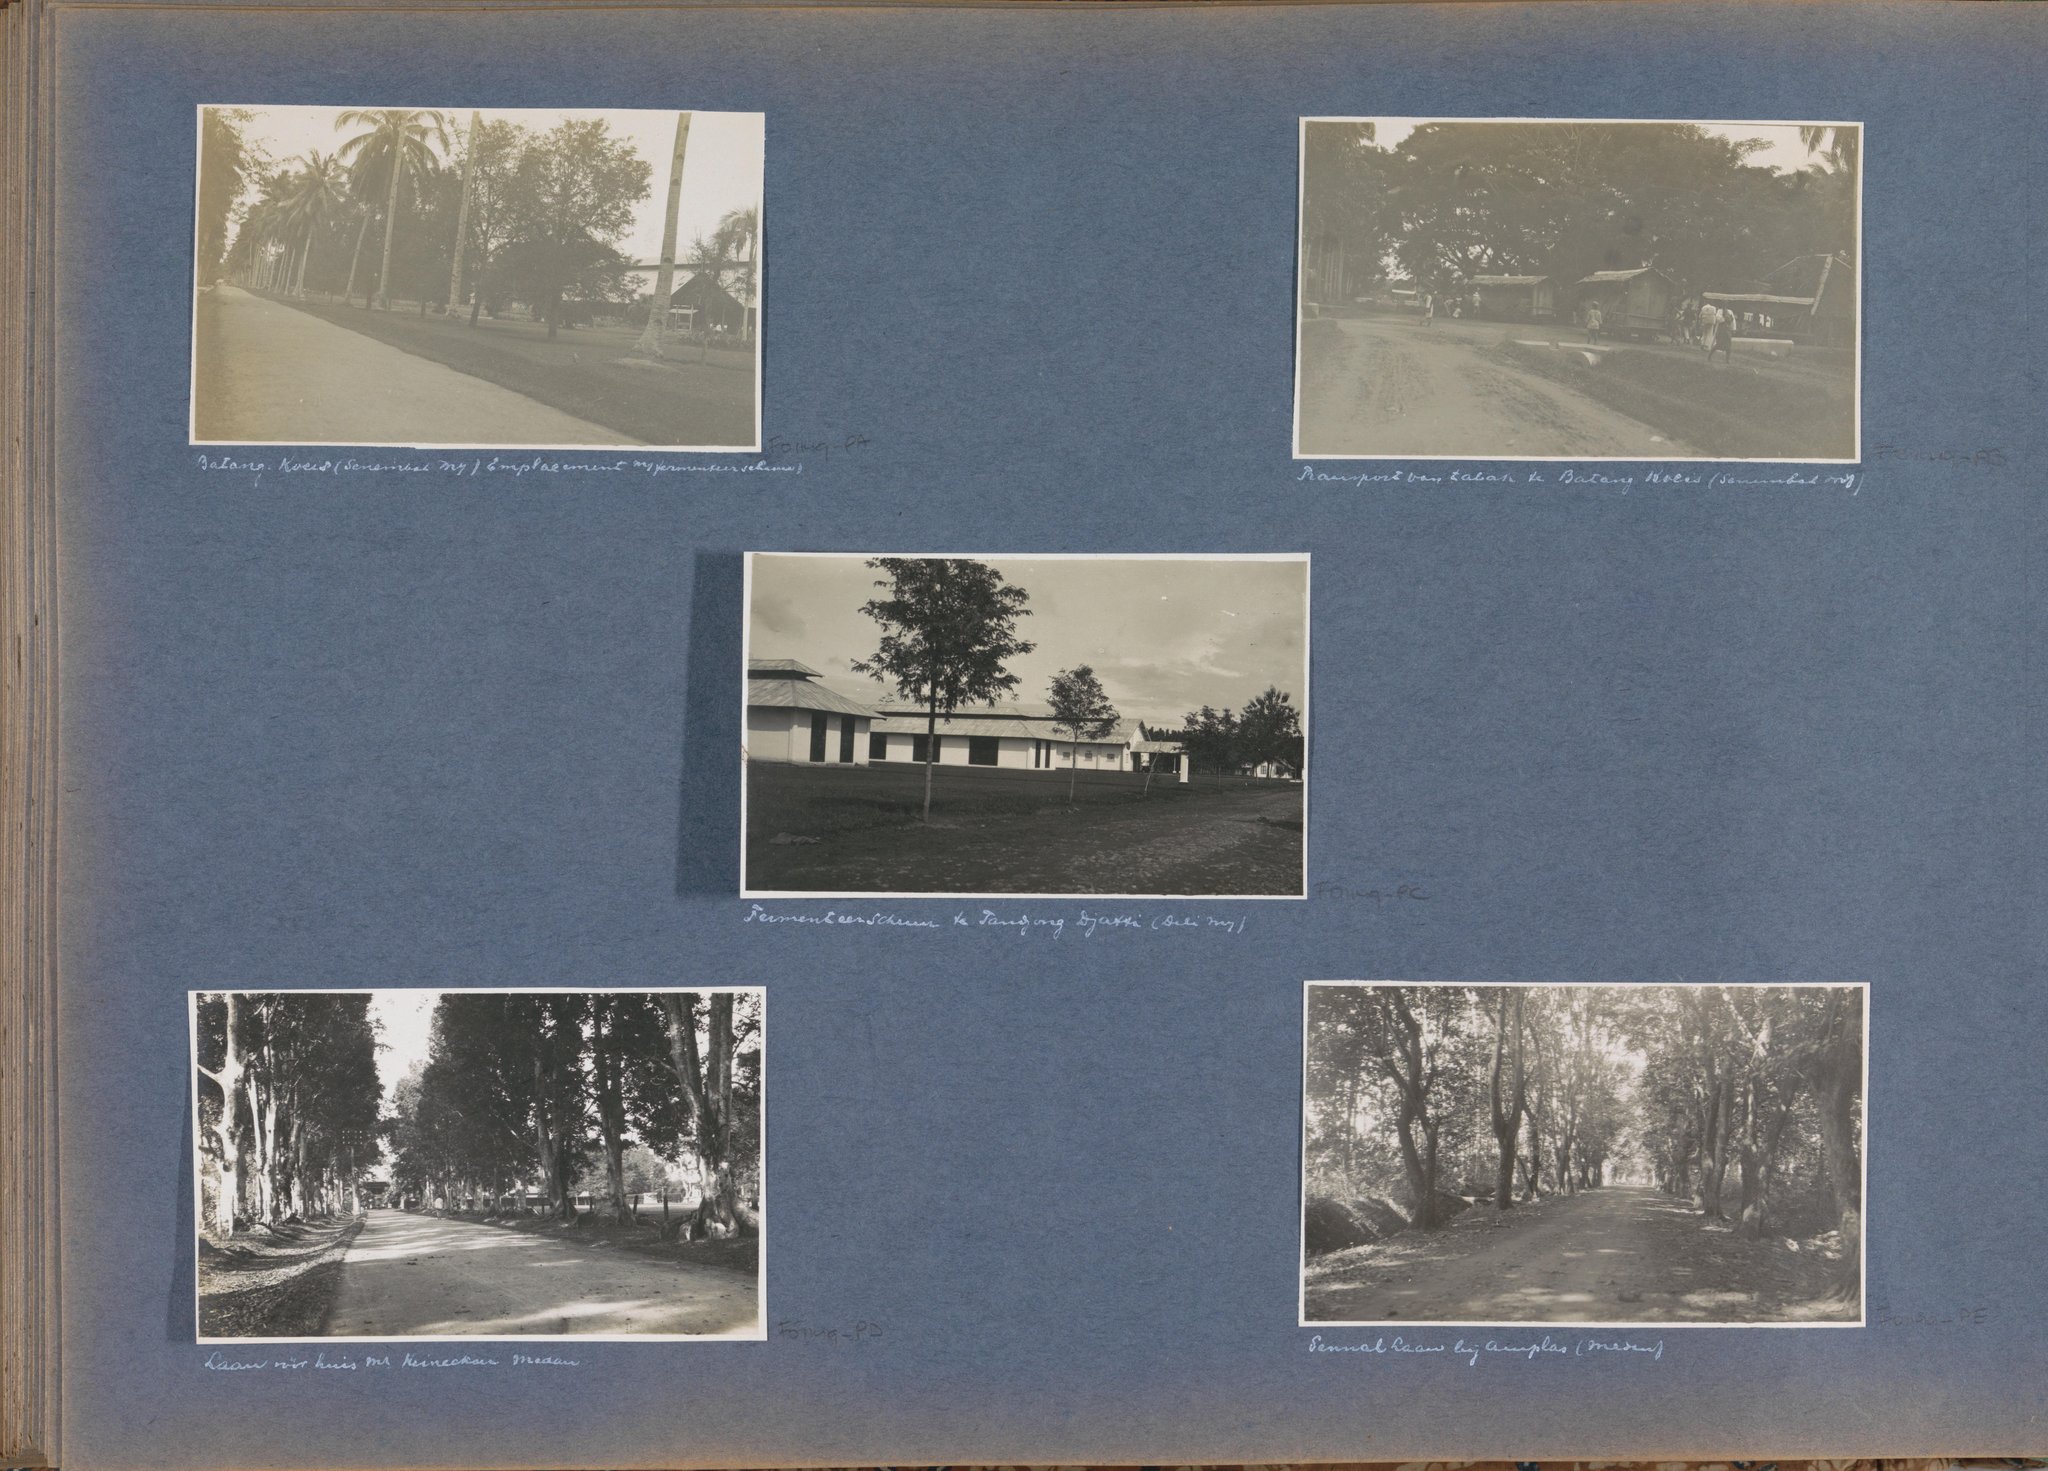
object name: photograph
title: Emplacement bij fermenteerschuur van de Senembah Maatschappij te Batang Kuis op Sumatra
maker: Anonymous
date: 1900-1920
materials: paper, photographic support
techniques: gelatin silver print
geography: sumatra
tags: plantation, barn, sumatra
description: Onderdeel van reisalbum met foto's van bedrijvigheid en bezienswaardigheden op Sumatra en Java en van de reis naar en van Nederlands-Indië.